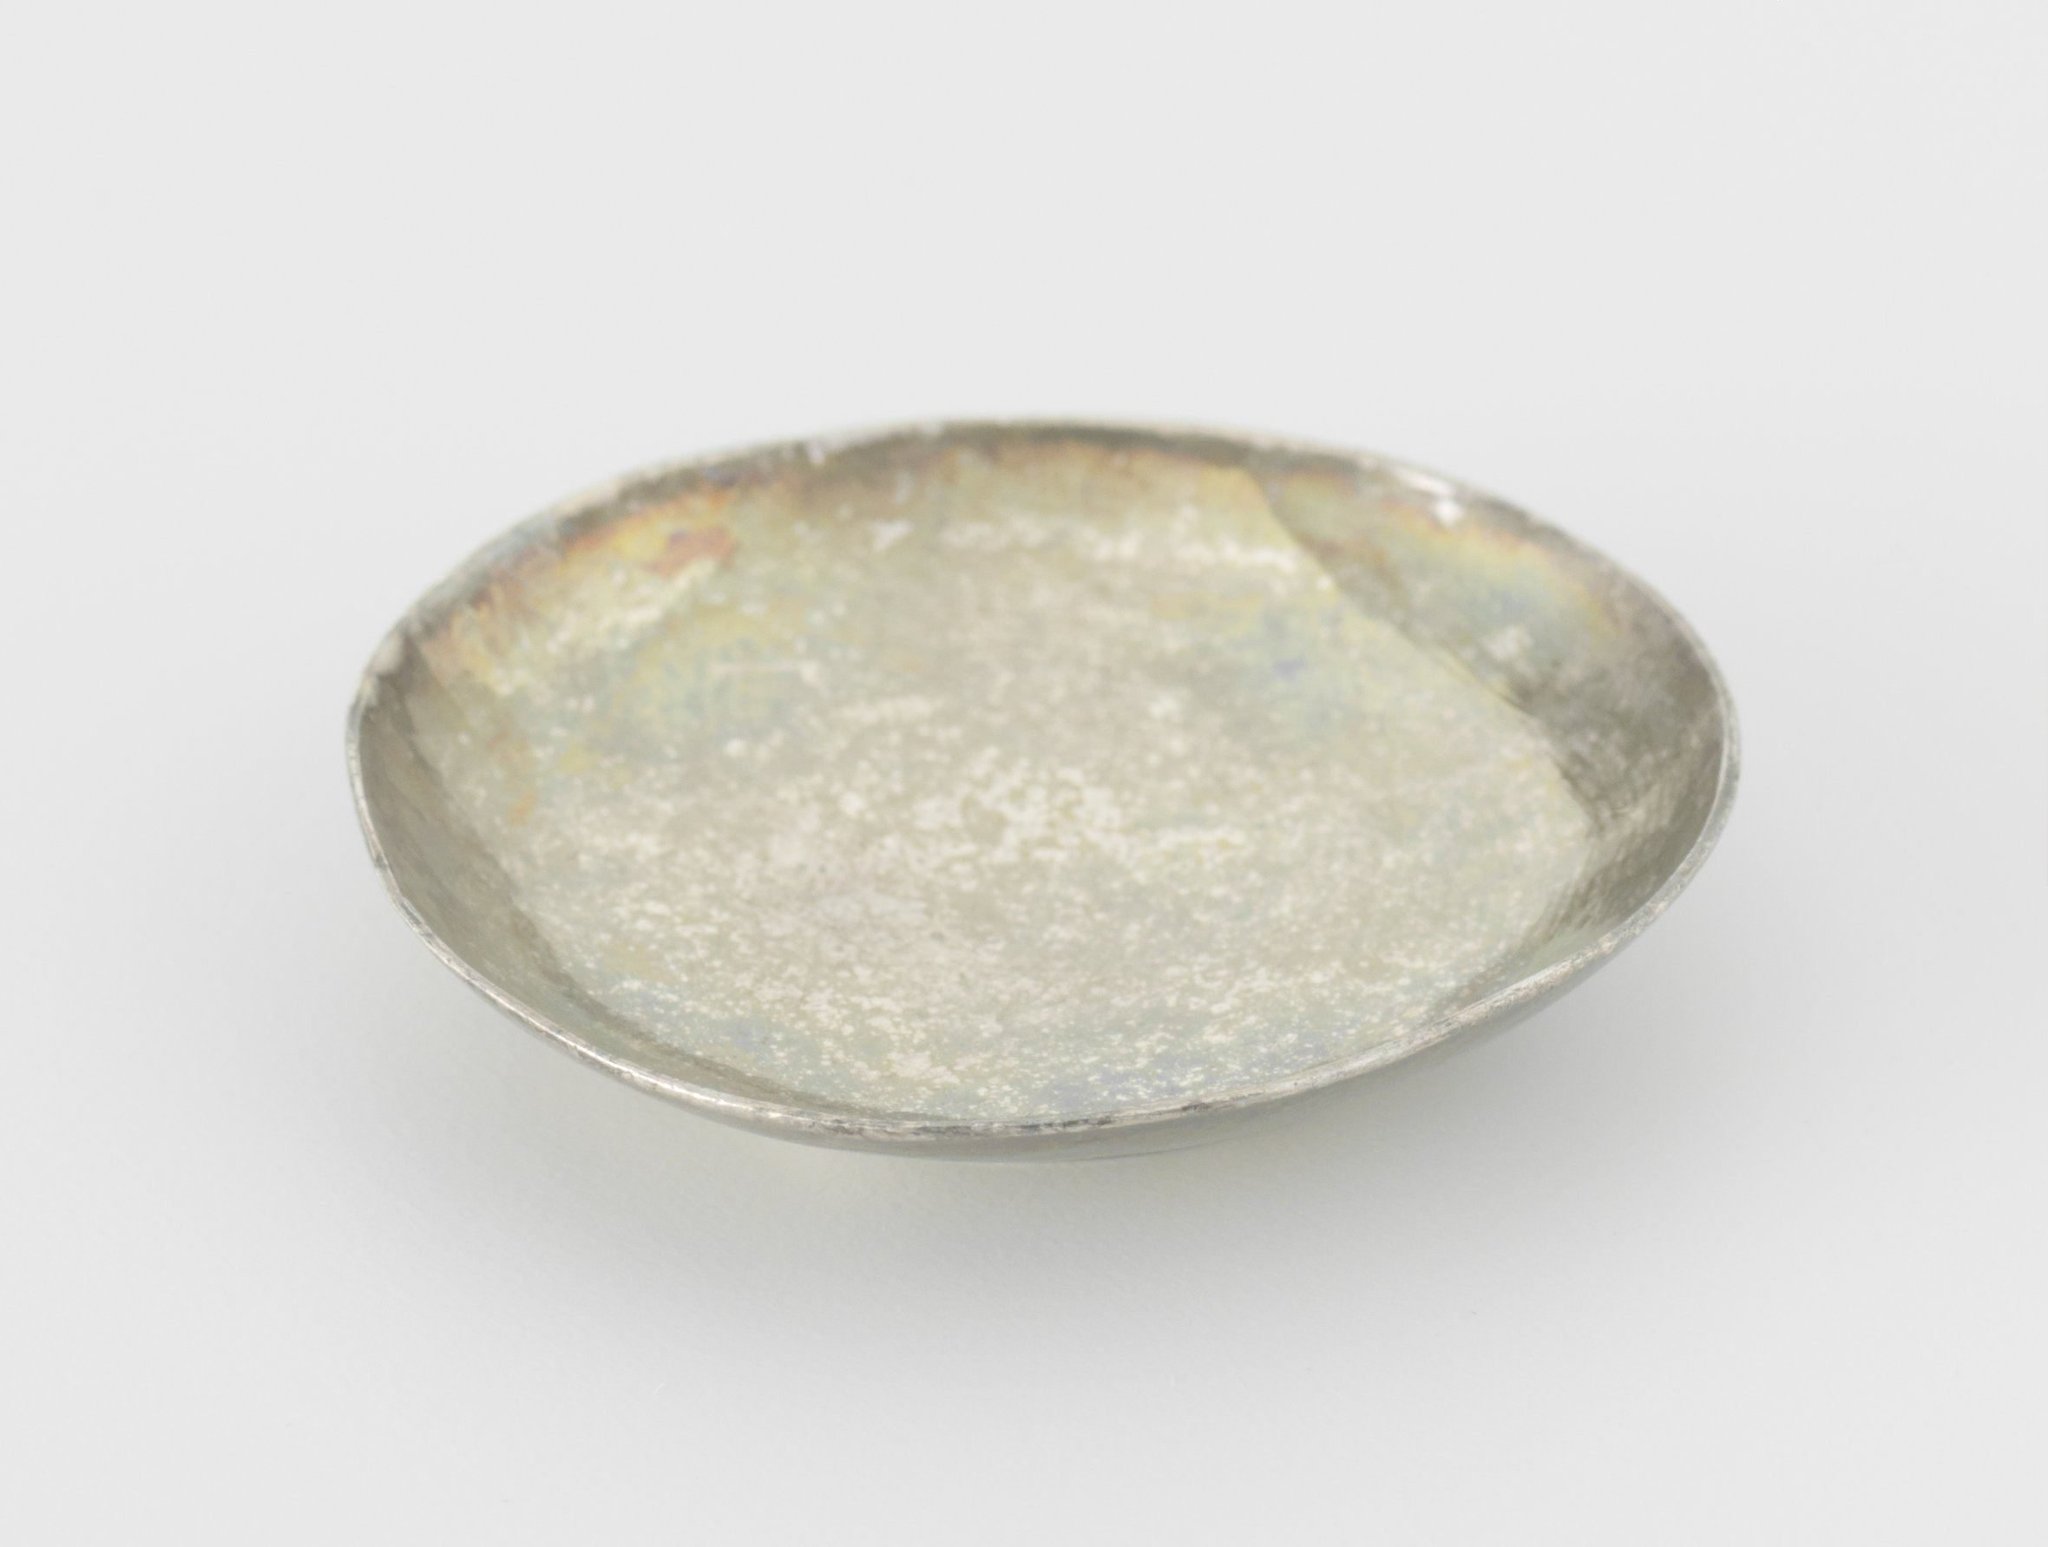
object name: miniature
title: Bord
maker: Anonymous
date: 1730-1760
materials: silver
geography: netherlands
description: Glad rond bord op een standring. Het bord is gemerkt met een letter Z (jrl?) en een onbekend merk. Het bord is gelijk aan het bord met invnr. BK-1977-64-a.